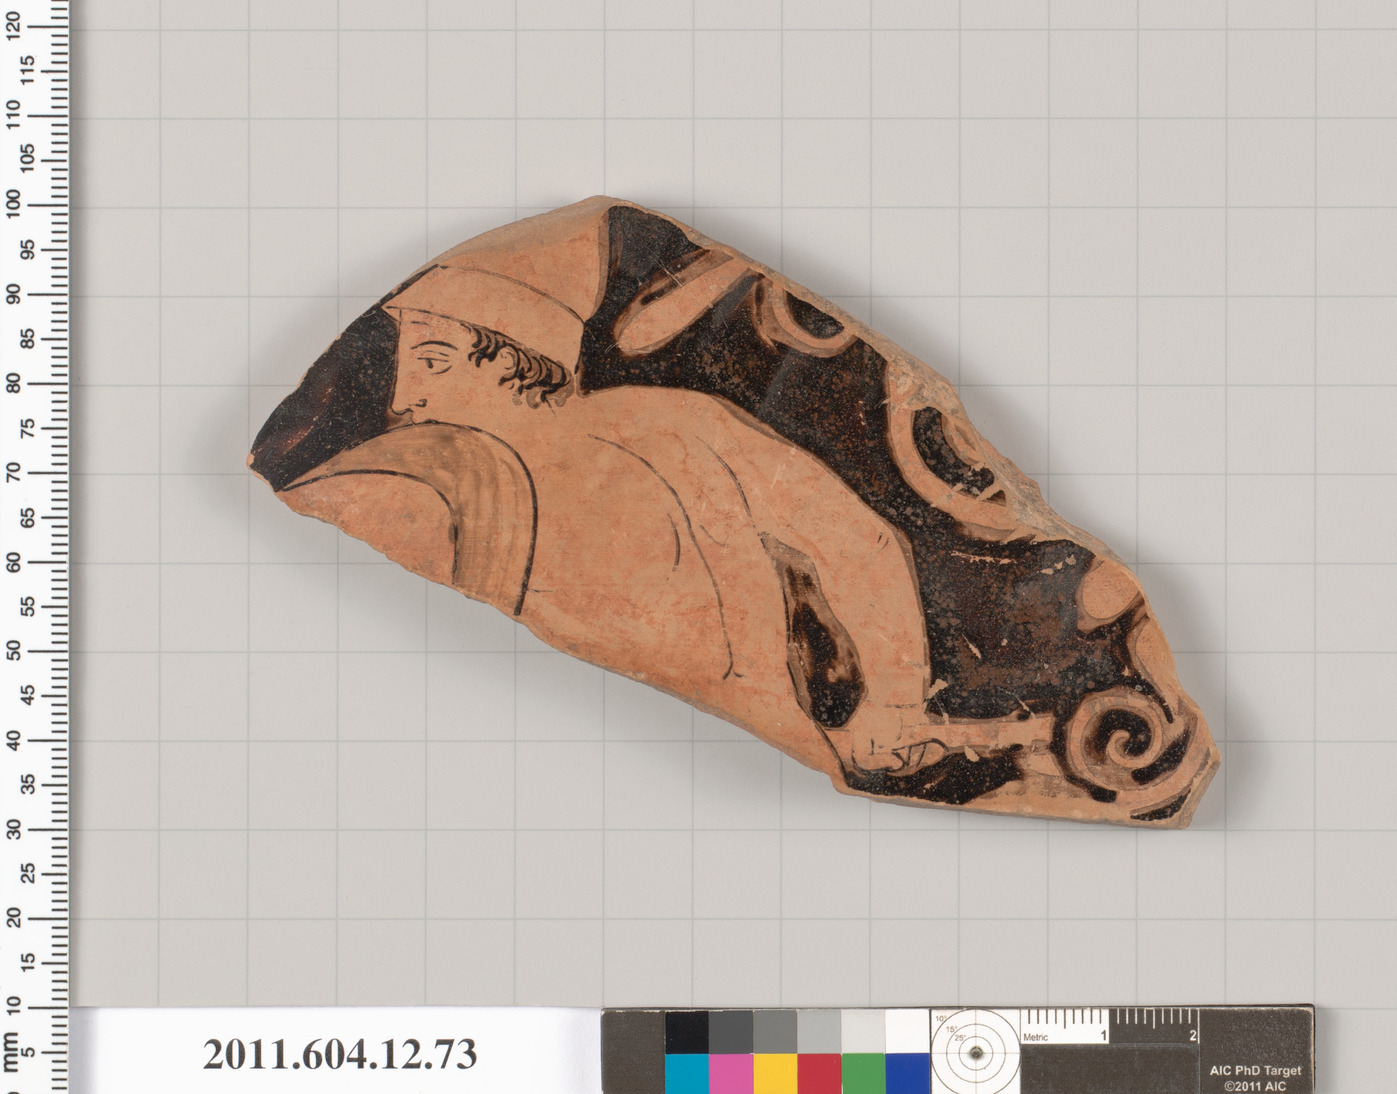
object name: krater fragment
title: Terracotta fragment of a krater (deep bowl)?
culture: greek or south italian or campanian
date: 367-335 BCE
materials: terracotta